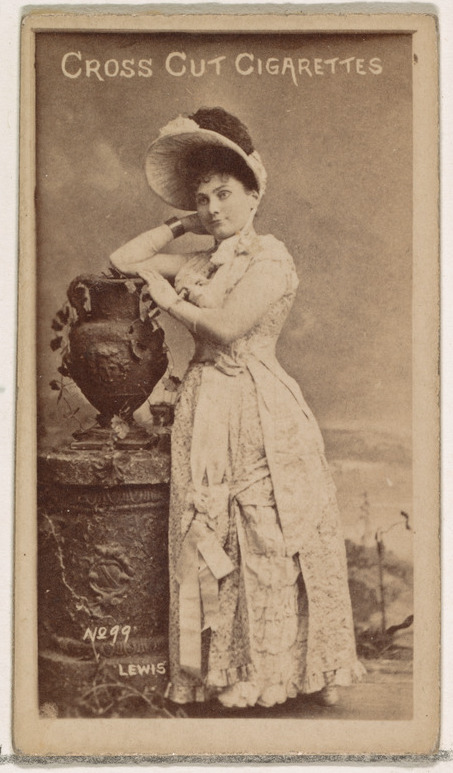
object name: print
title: Card Number 99, Lewis, from the Actors and Actresses series (N145-1) issued by Duke Sons & Co. to promote Cross Cut Cigarettes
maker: w. duke, sons & co.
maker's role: publisher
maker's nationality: american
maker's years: 1870-1920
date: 1880-1889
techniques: albumen silver print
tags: portraits,women,actresses